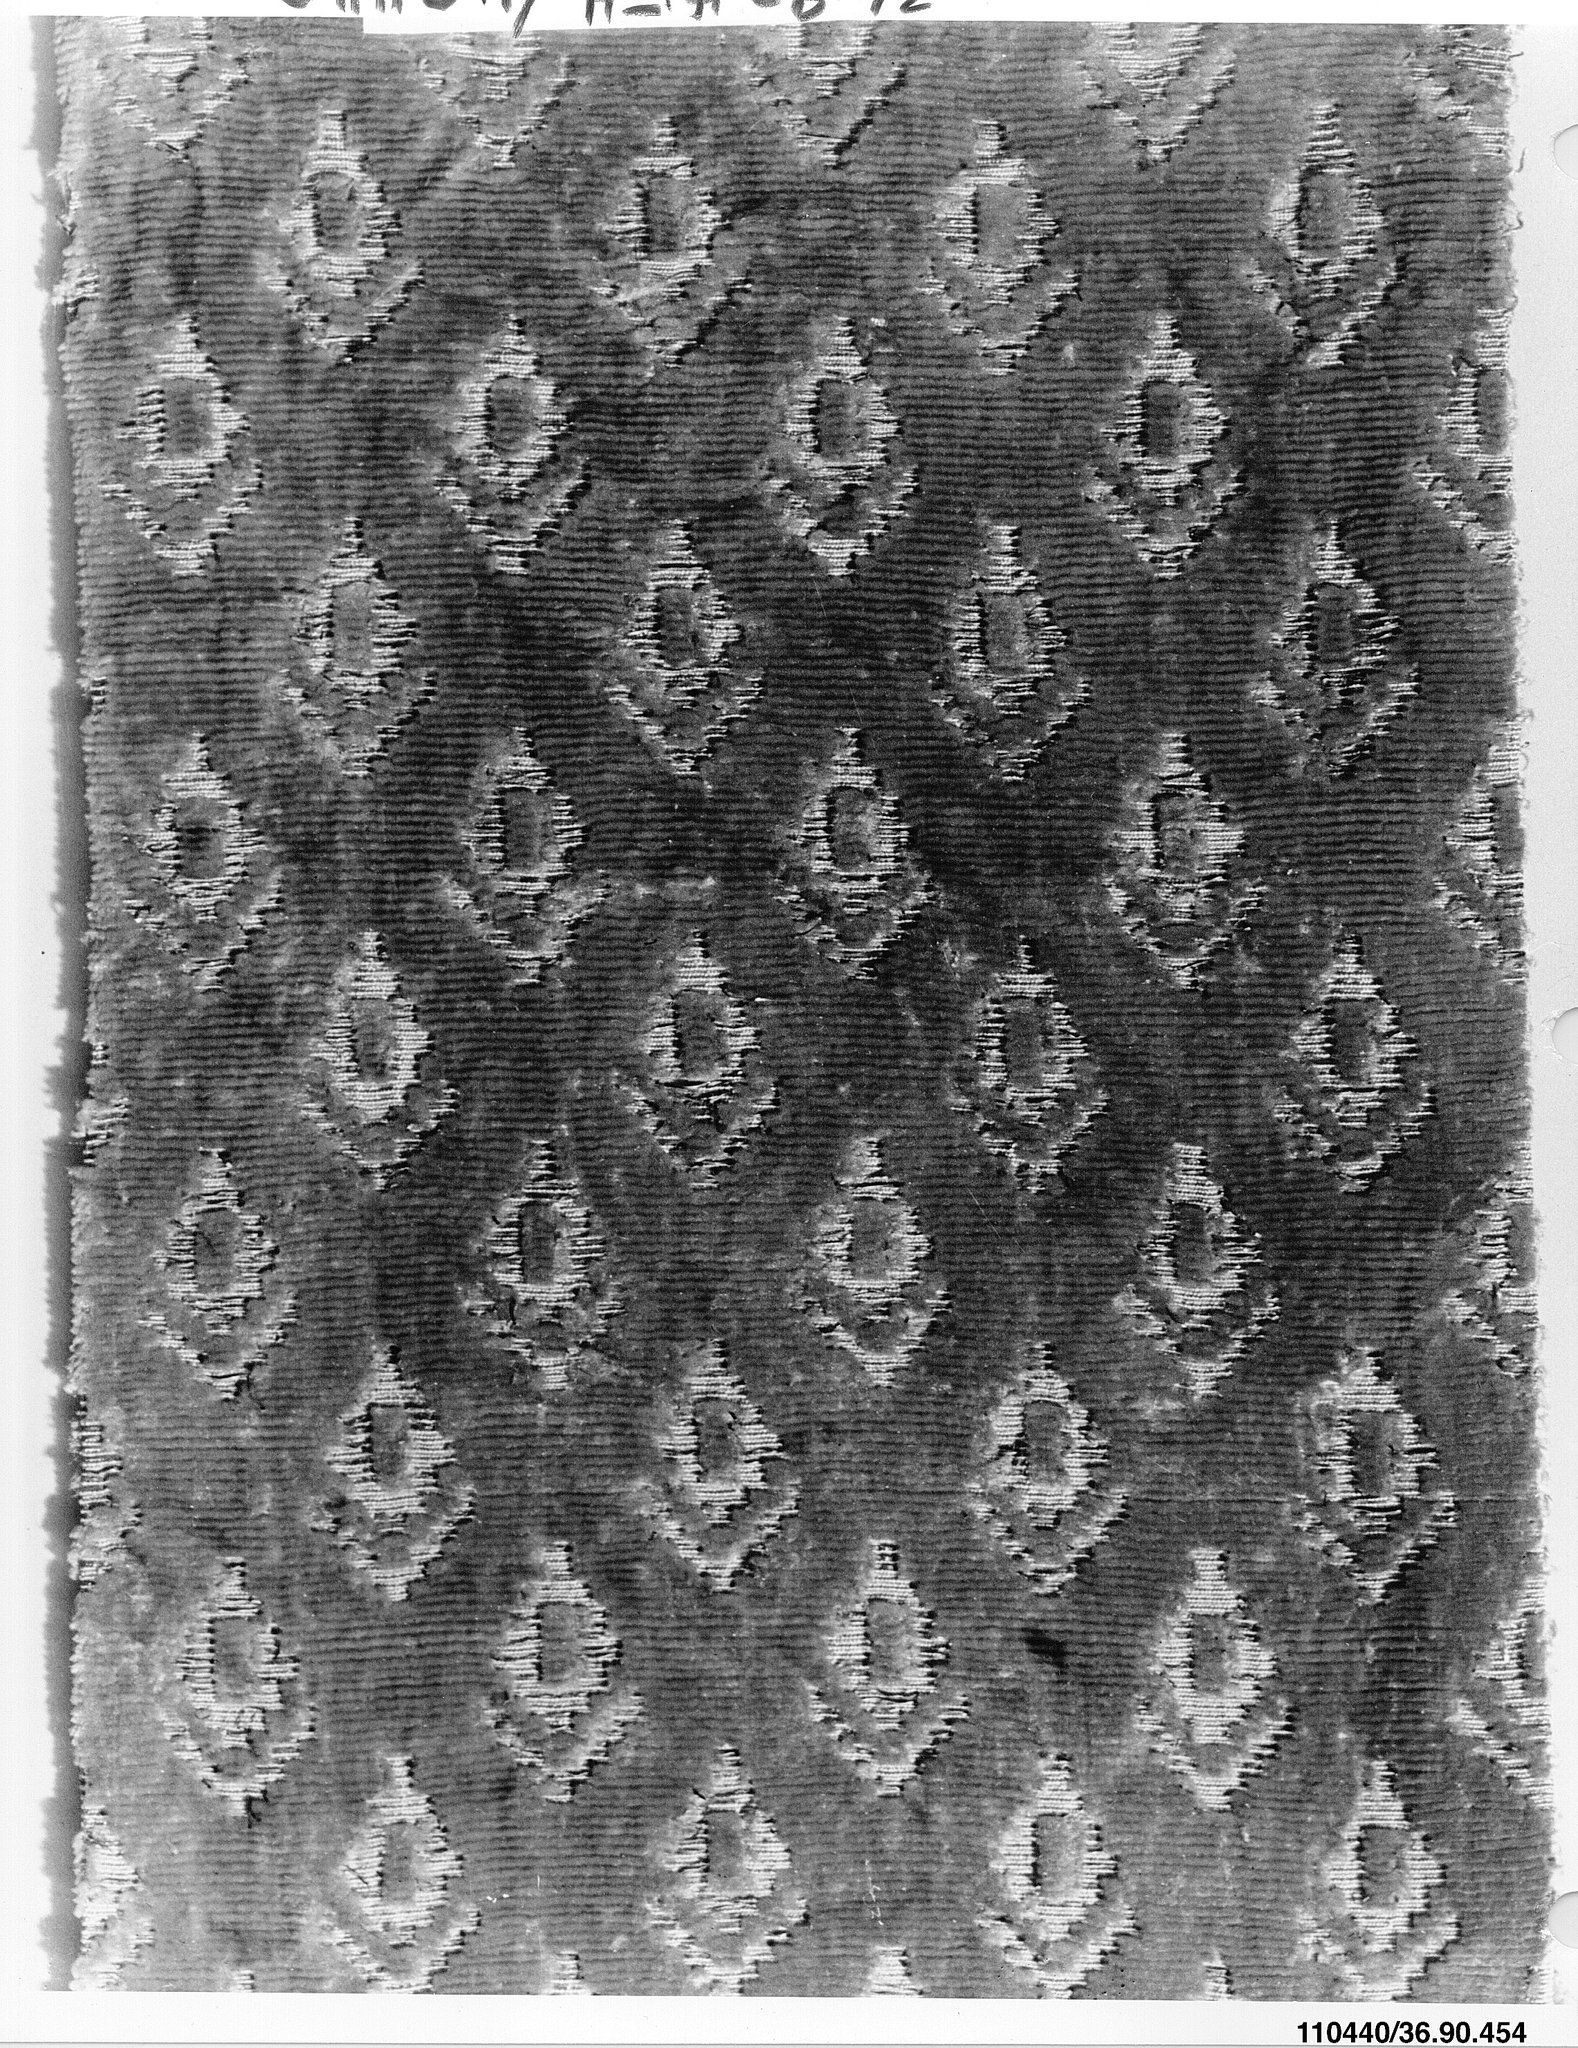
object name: piece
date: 1501-1700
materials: metal thread, silk